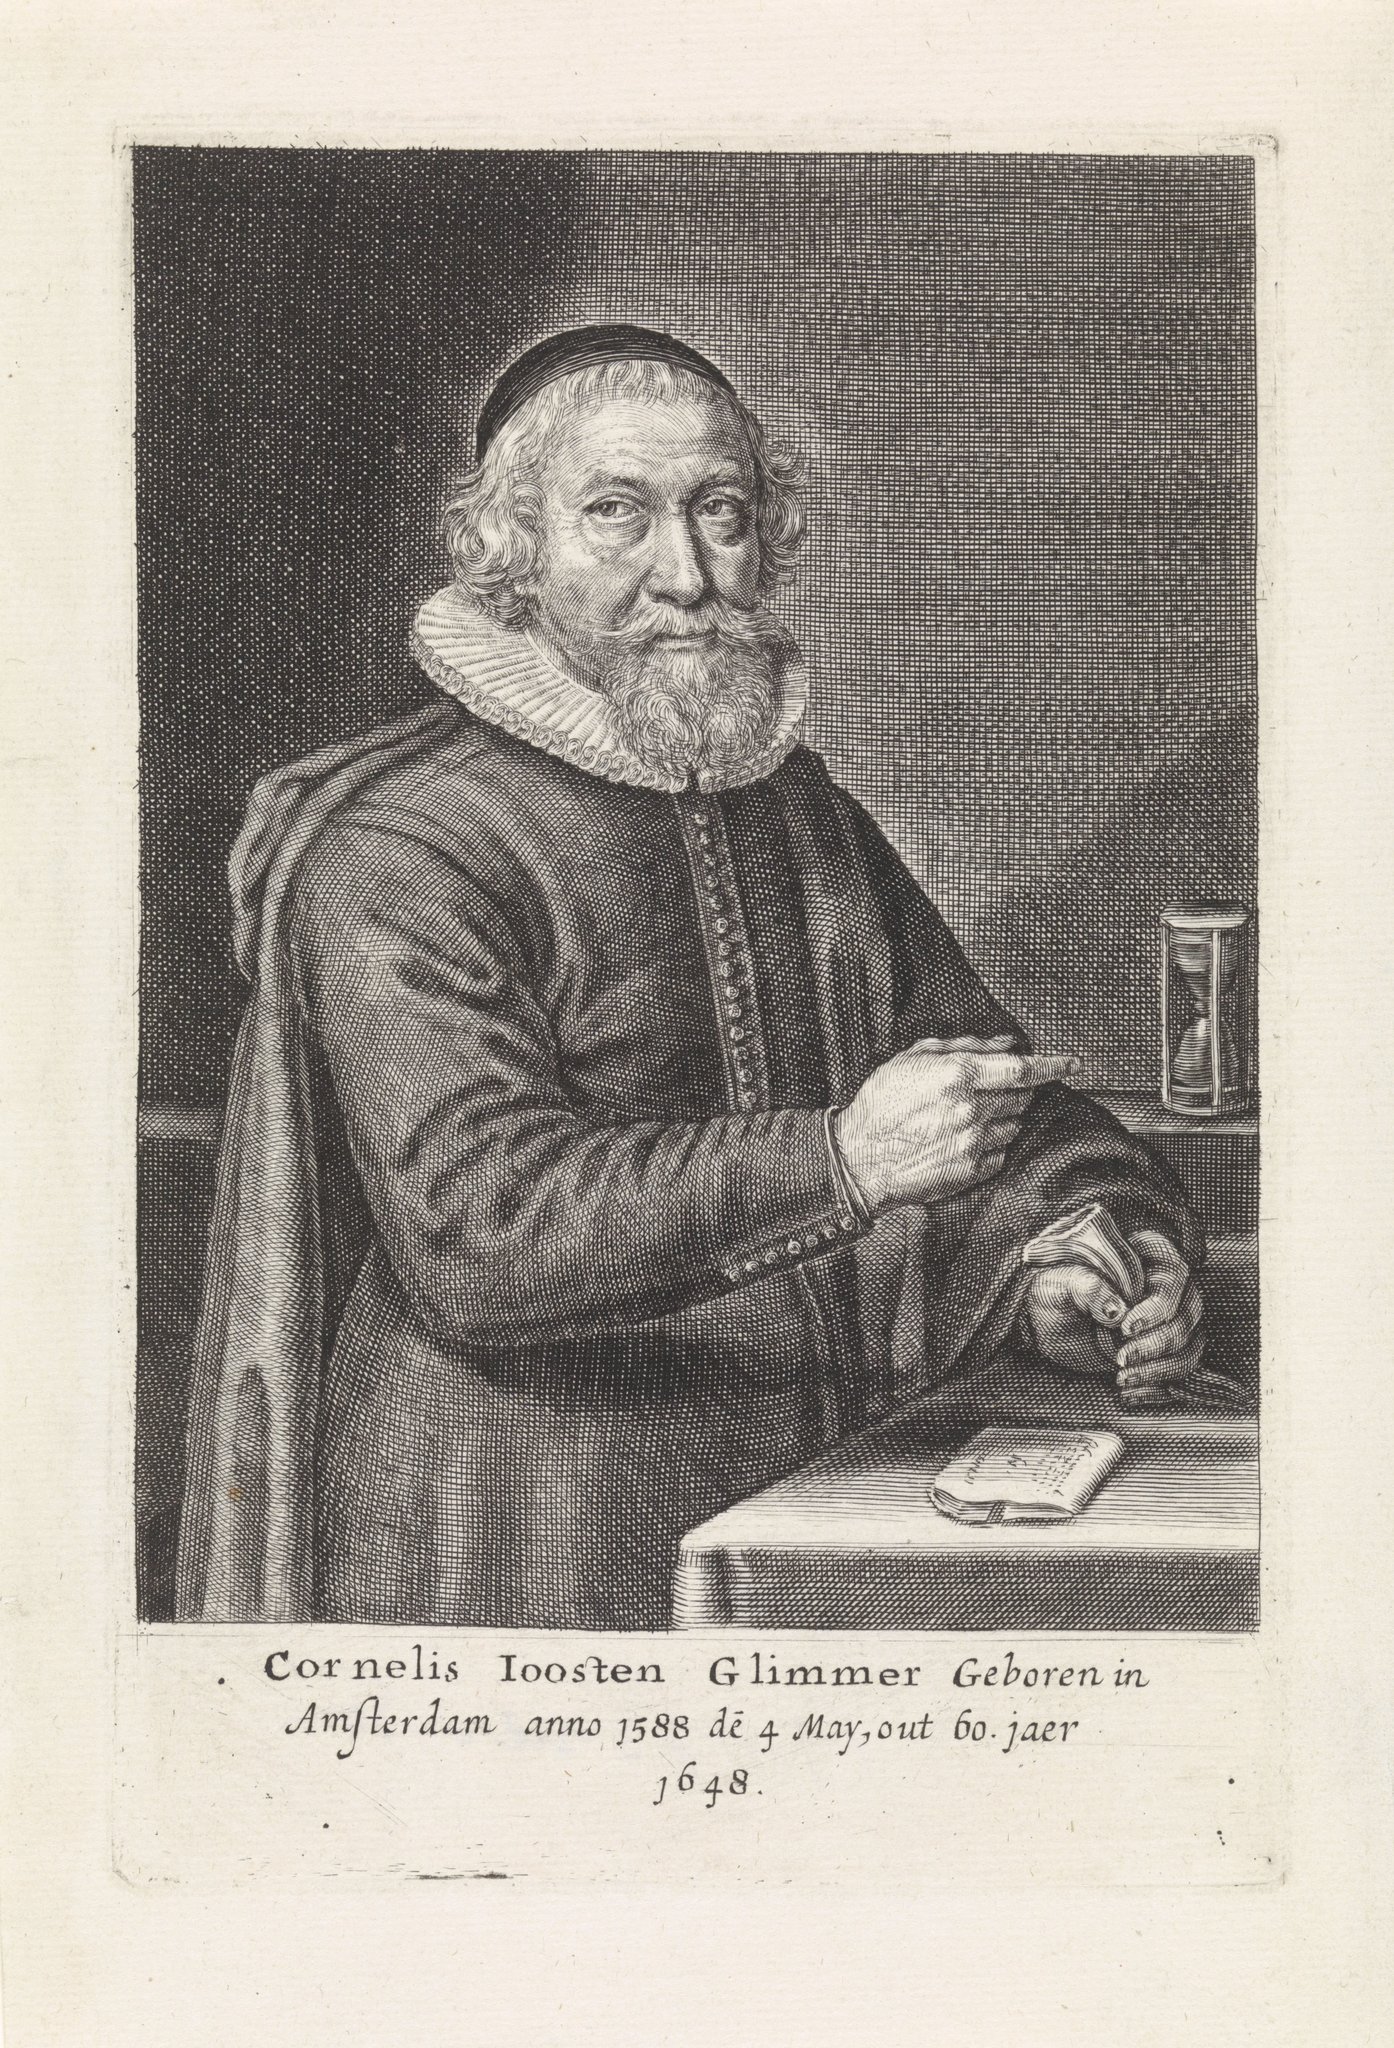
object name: print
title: Portret van Cornelis Joosten Glimmer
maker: crispijn van de passe (ii)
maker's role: draughtsman, print maker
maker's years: 1594-1670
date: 1648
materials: paper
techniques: engraving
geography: amsterdam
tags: hourglass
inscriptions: collector's mark: Lugt 2228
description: Portret van Cornelis Joosten Glimmer, leraar der Doopsgezinden te Amsterdam, op 60-jarige leeftijd. Hij wijst naar een zandloper, die de vergankelijkheid van het leven symboliseert.